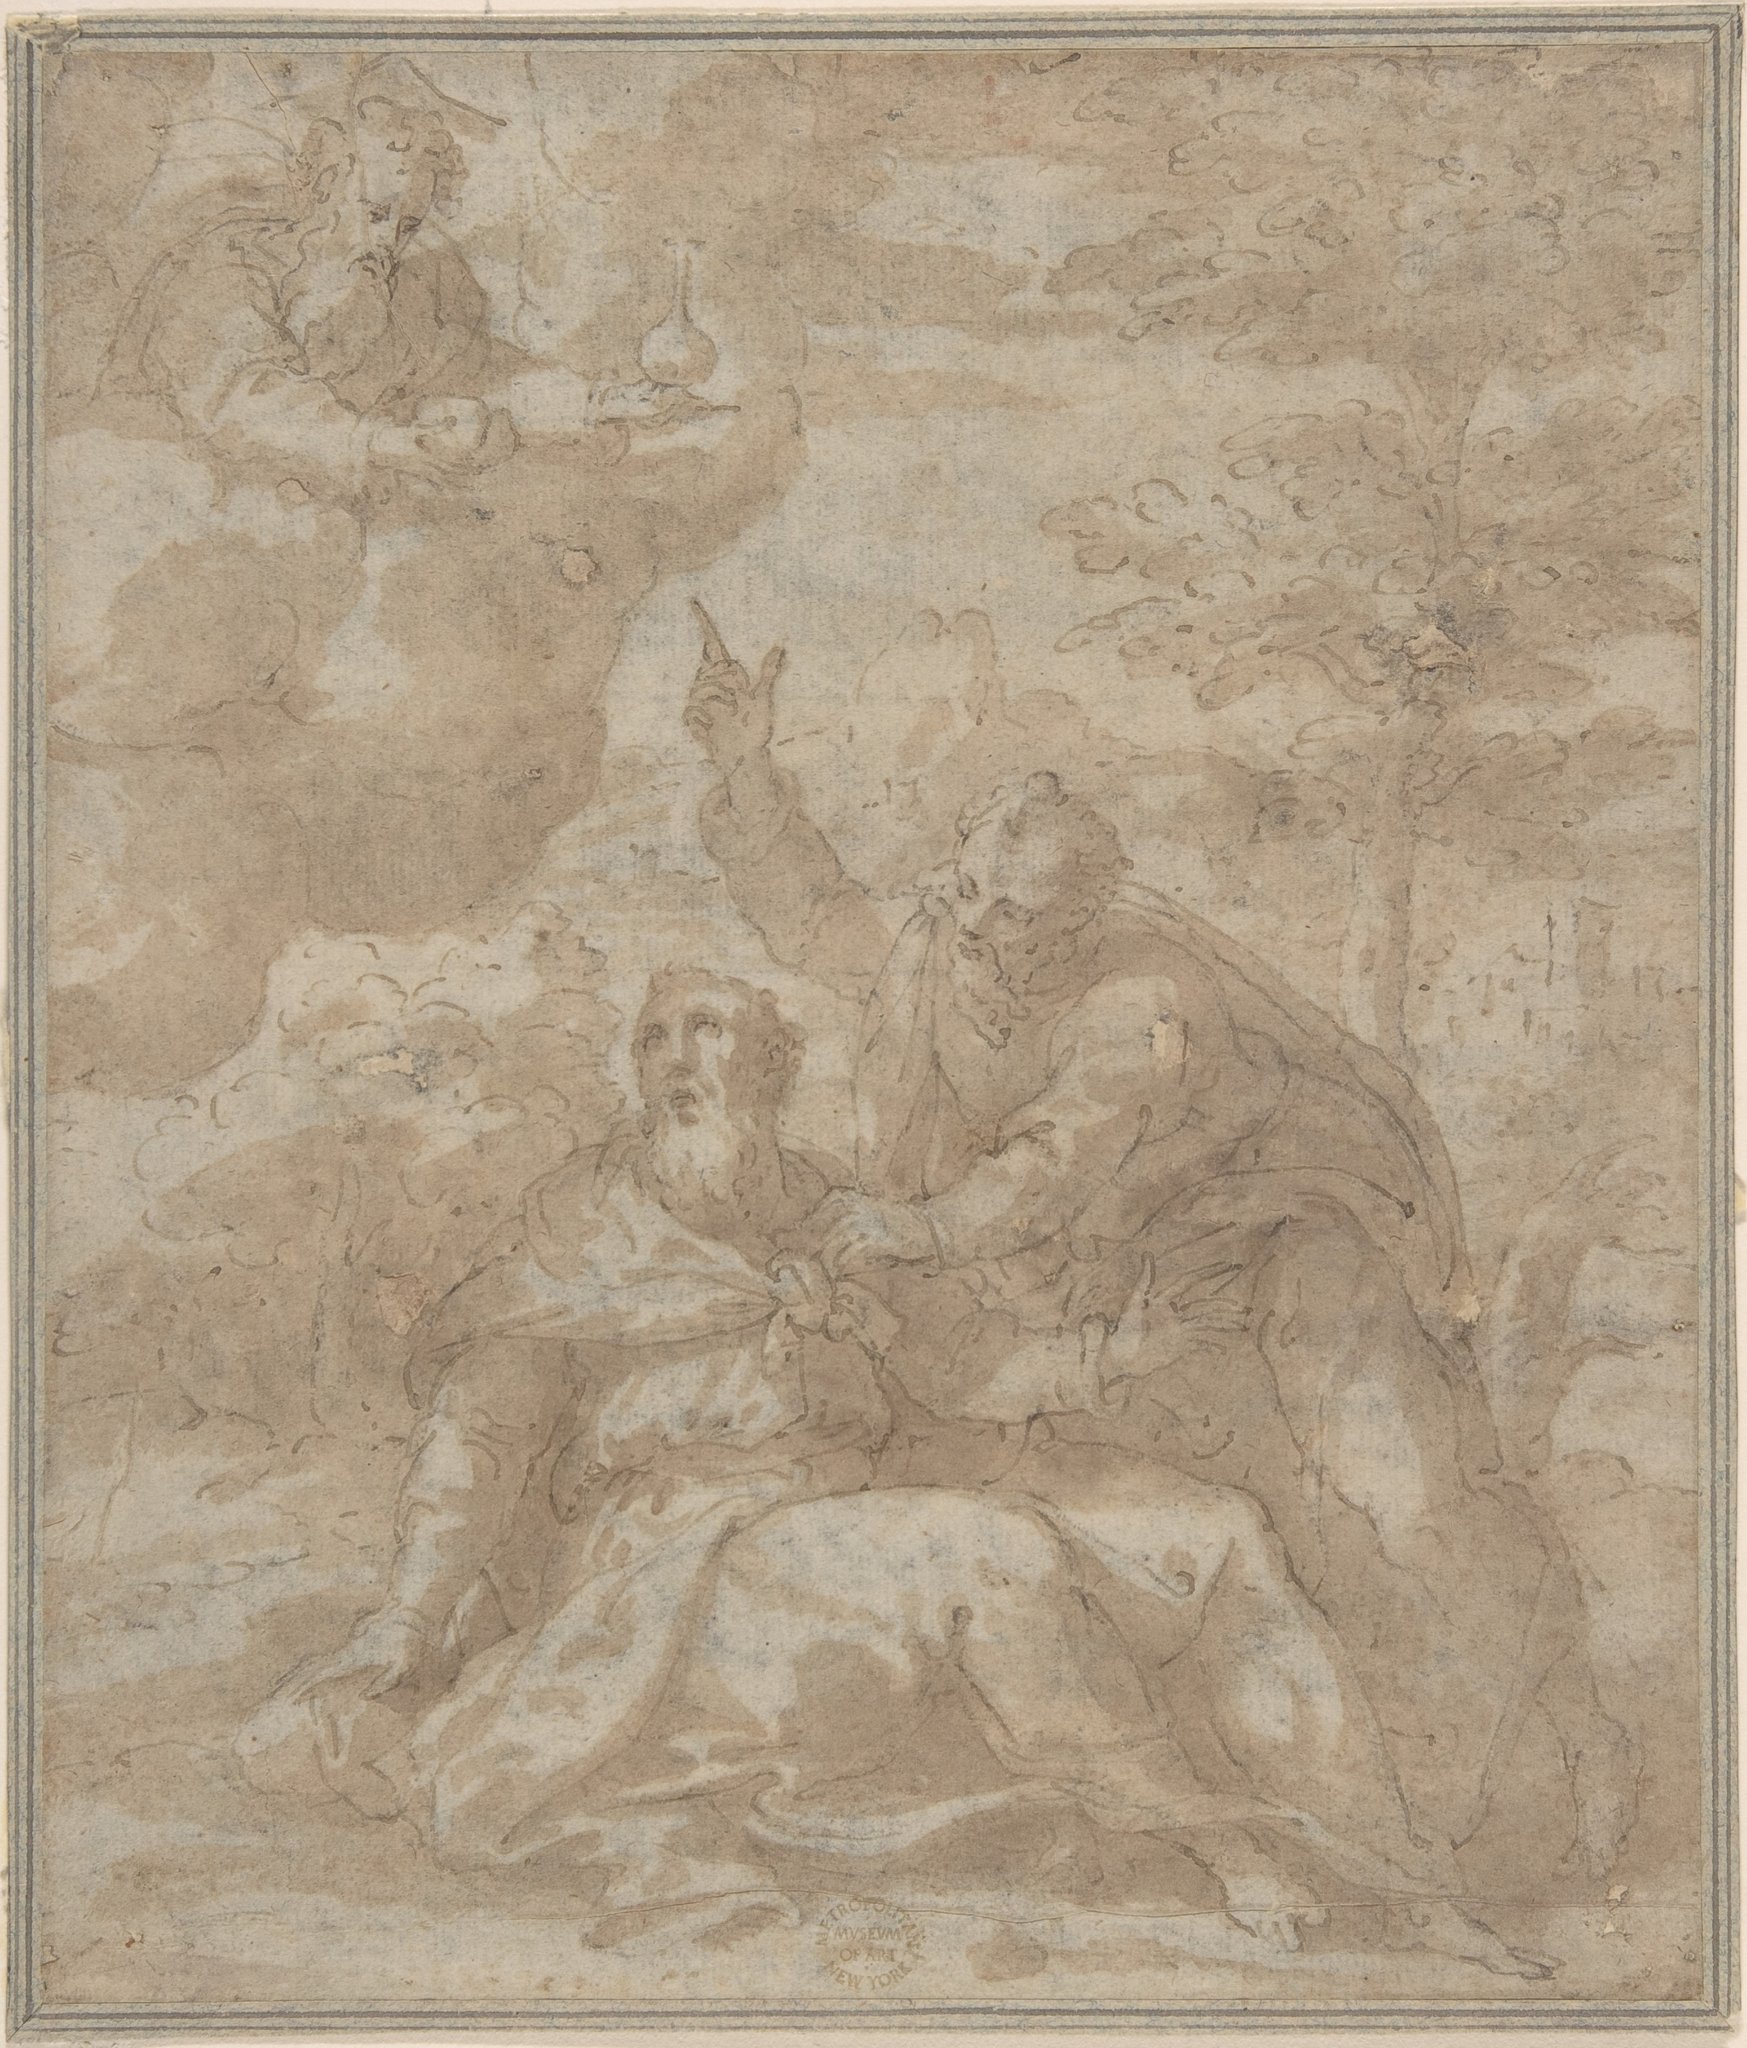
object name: drawing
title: Death of a Saint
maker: anonymous, italian, roman-bolognese, 17th century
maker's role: artist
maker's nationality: italian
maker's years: 1600-1700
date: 1601-1700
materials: charcoal, ink, paper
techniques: brush, pen, wash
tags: men,trees,saints,death